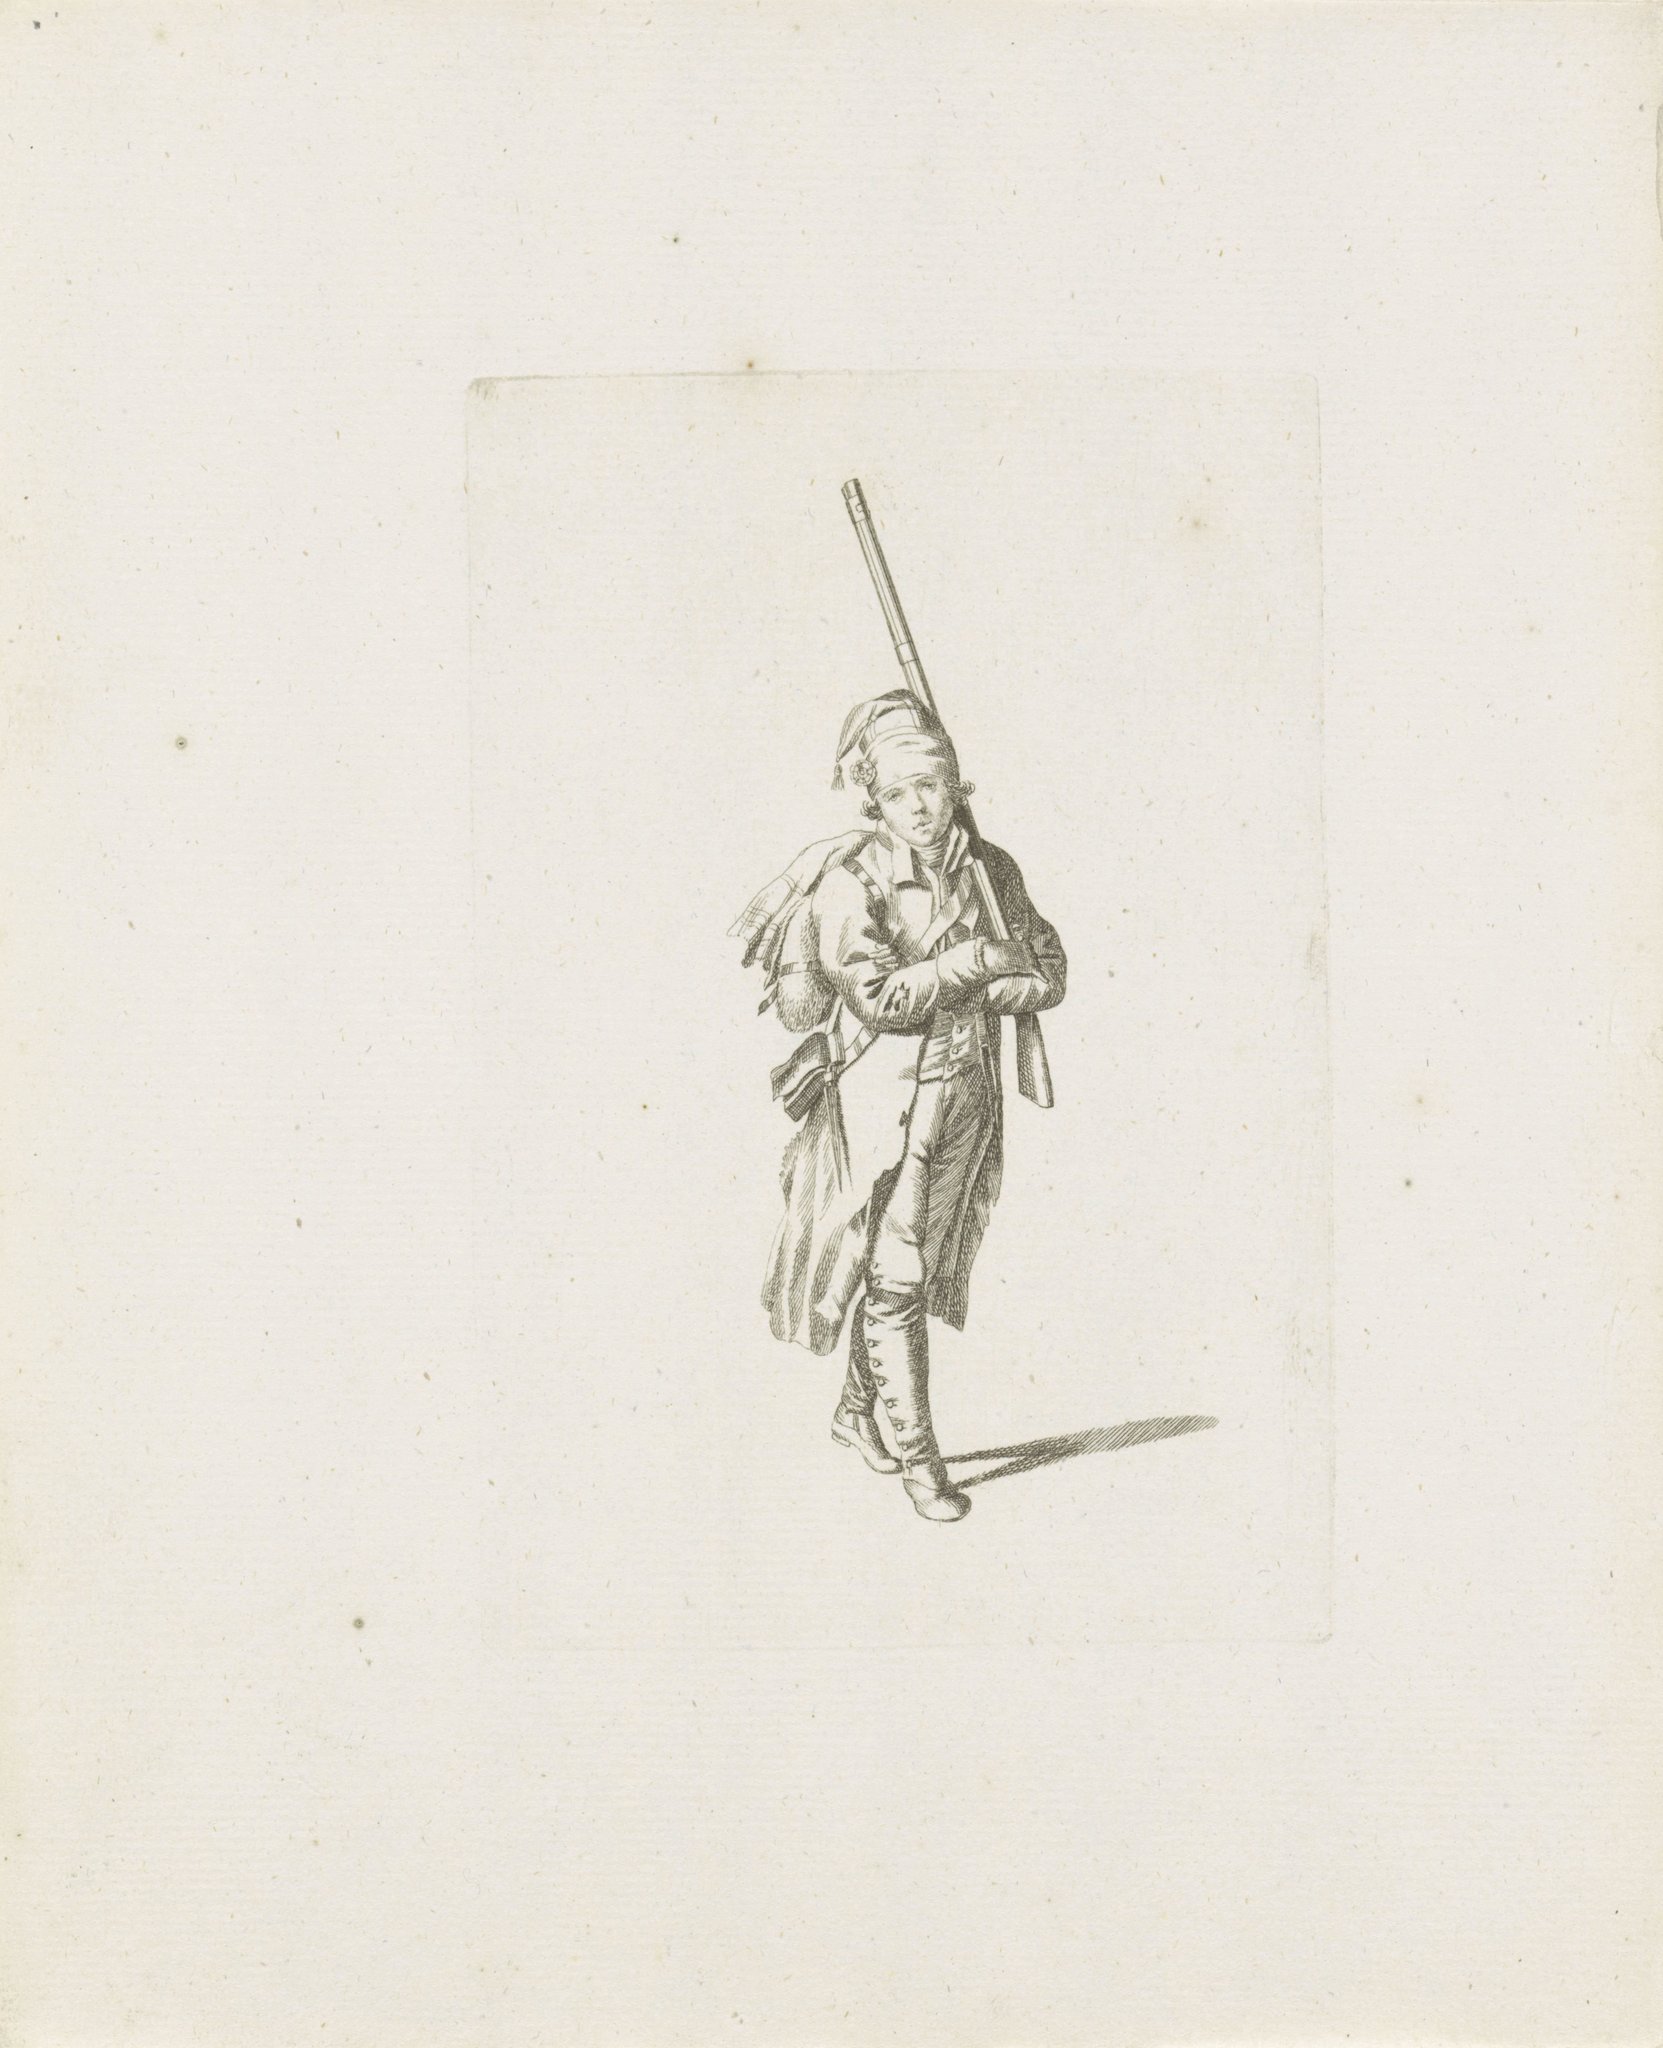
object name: print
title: Staande Franse soldaat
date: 1795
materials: paper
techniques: engraving, etching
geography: northern netherlands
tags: (military) uniforms (+ infantry), clothes, costume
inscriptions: collector's mark: Lugt 2228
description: Een staande Franse soldaat, naar rechts. Onderdeel van een serie van vijftien platen van Franse infanterie, vooral soldaten en enkele officieren, in ongeregelde uniform of kleding, zoals deze in 1795 in de Republiek aankwam.